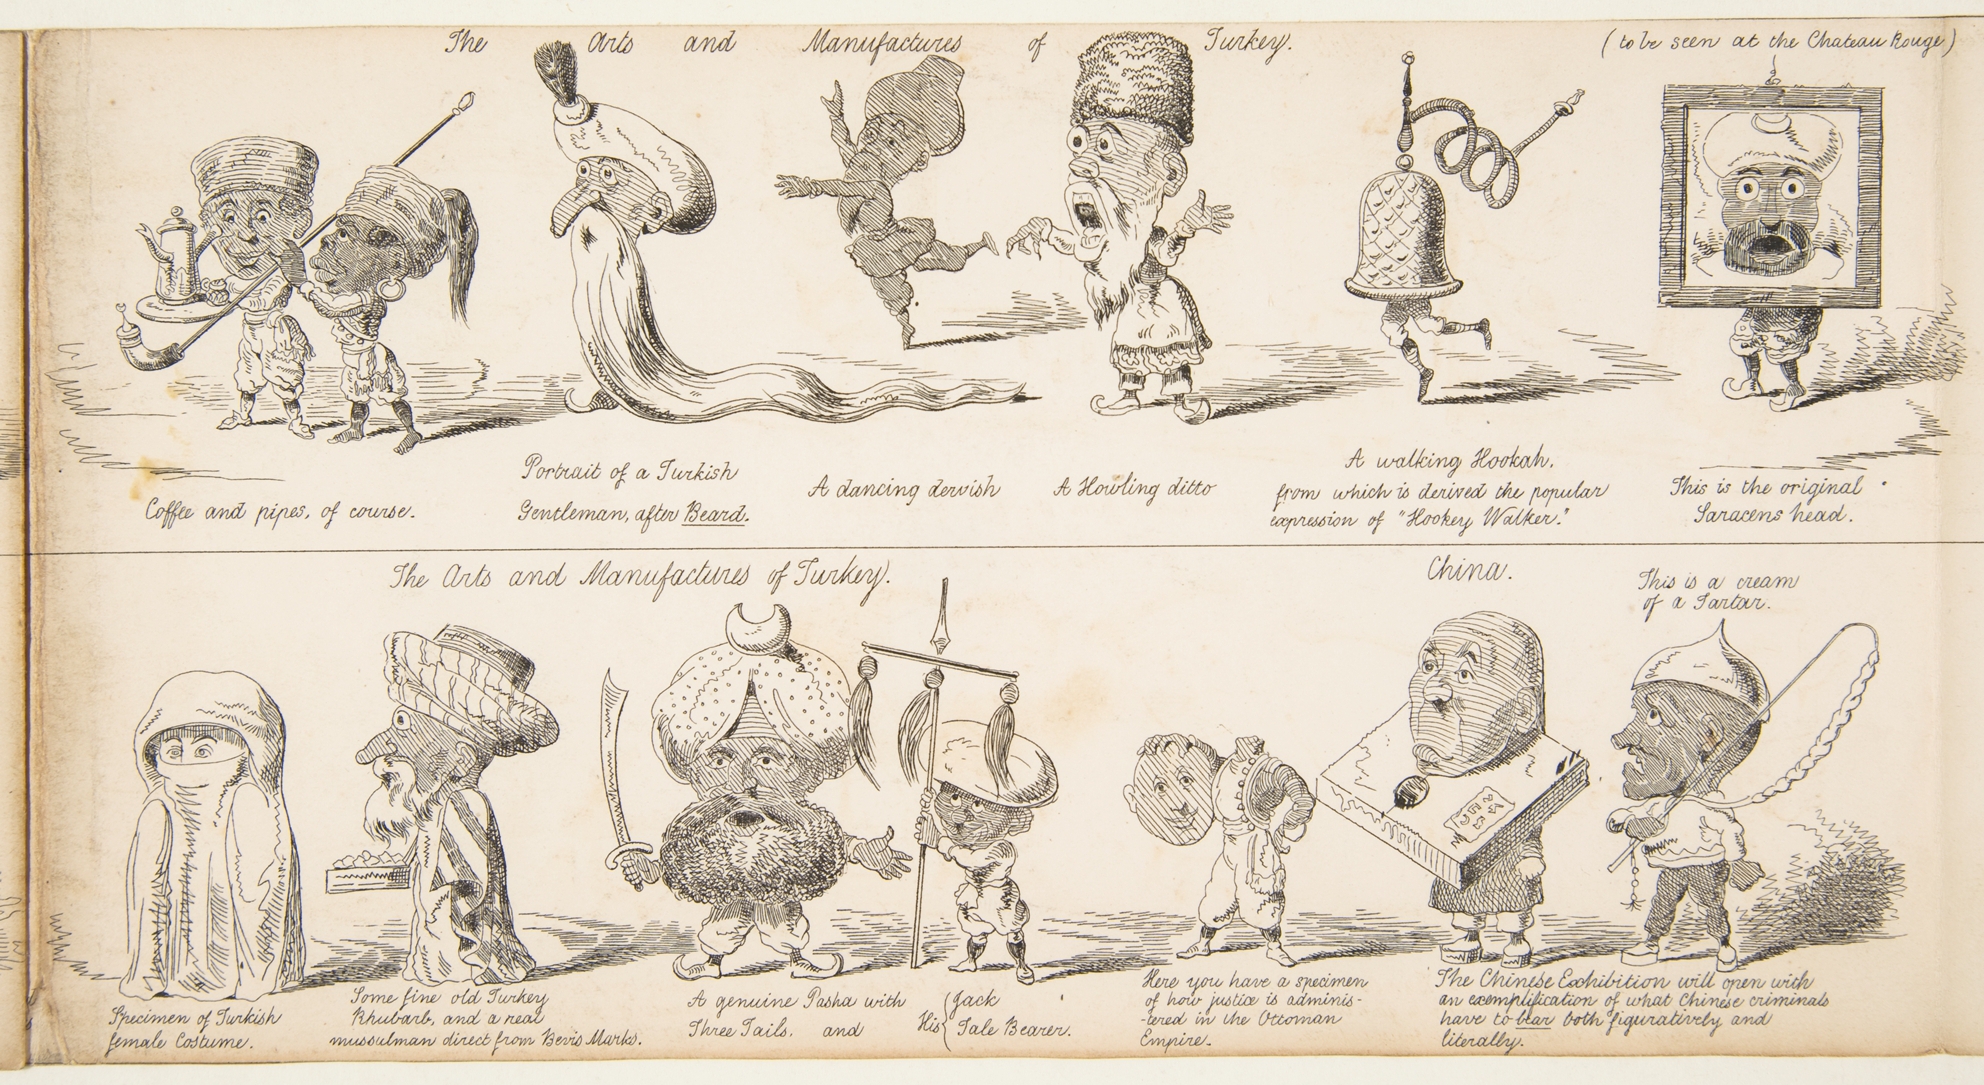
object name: print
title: The Great Exhibition "Wot is to Be", Probable Results of The Industry of All Nations in The Year '51, Showing What is to be Exhibited, Who is To Exhibit, in Short How Its All Going to Be Done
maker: george augustus sala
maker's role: author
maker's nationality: british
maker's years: 1828-1895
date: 1850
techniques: engraving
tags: satire